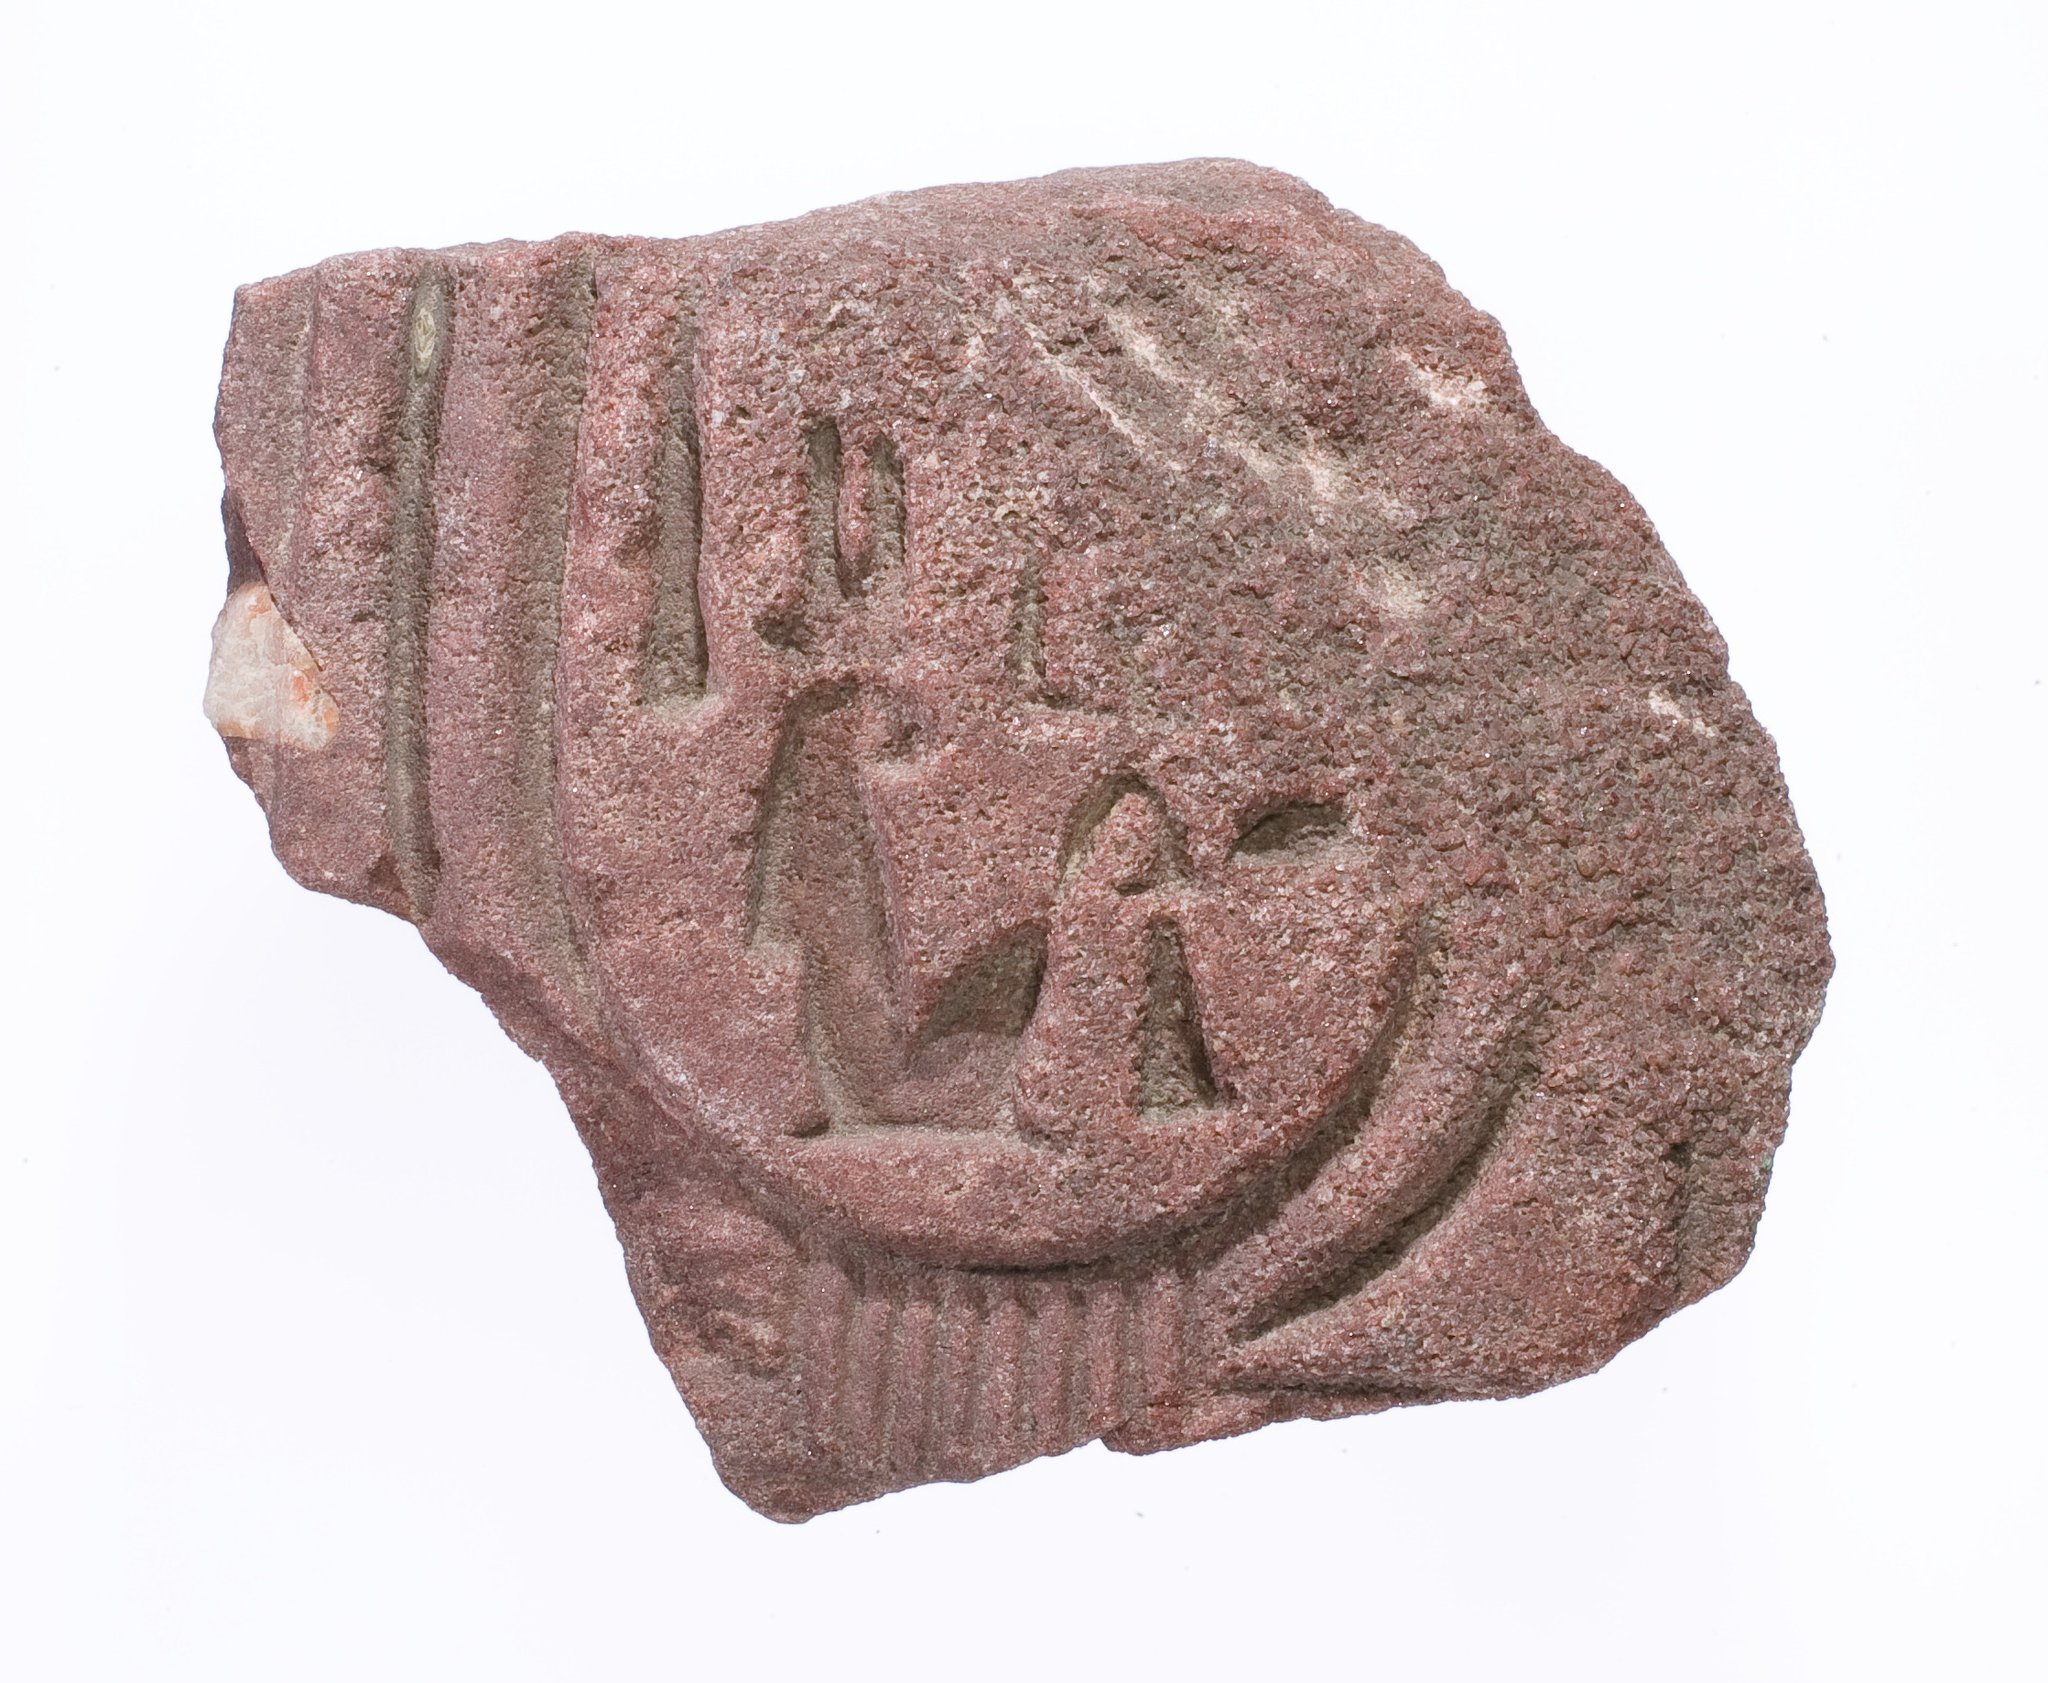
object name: cartouche of nefertiti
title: Fragment with the cartouche of Nefertiti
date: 1353-1336 BCE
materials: quartzite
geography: egypt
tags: nefertiti